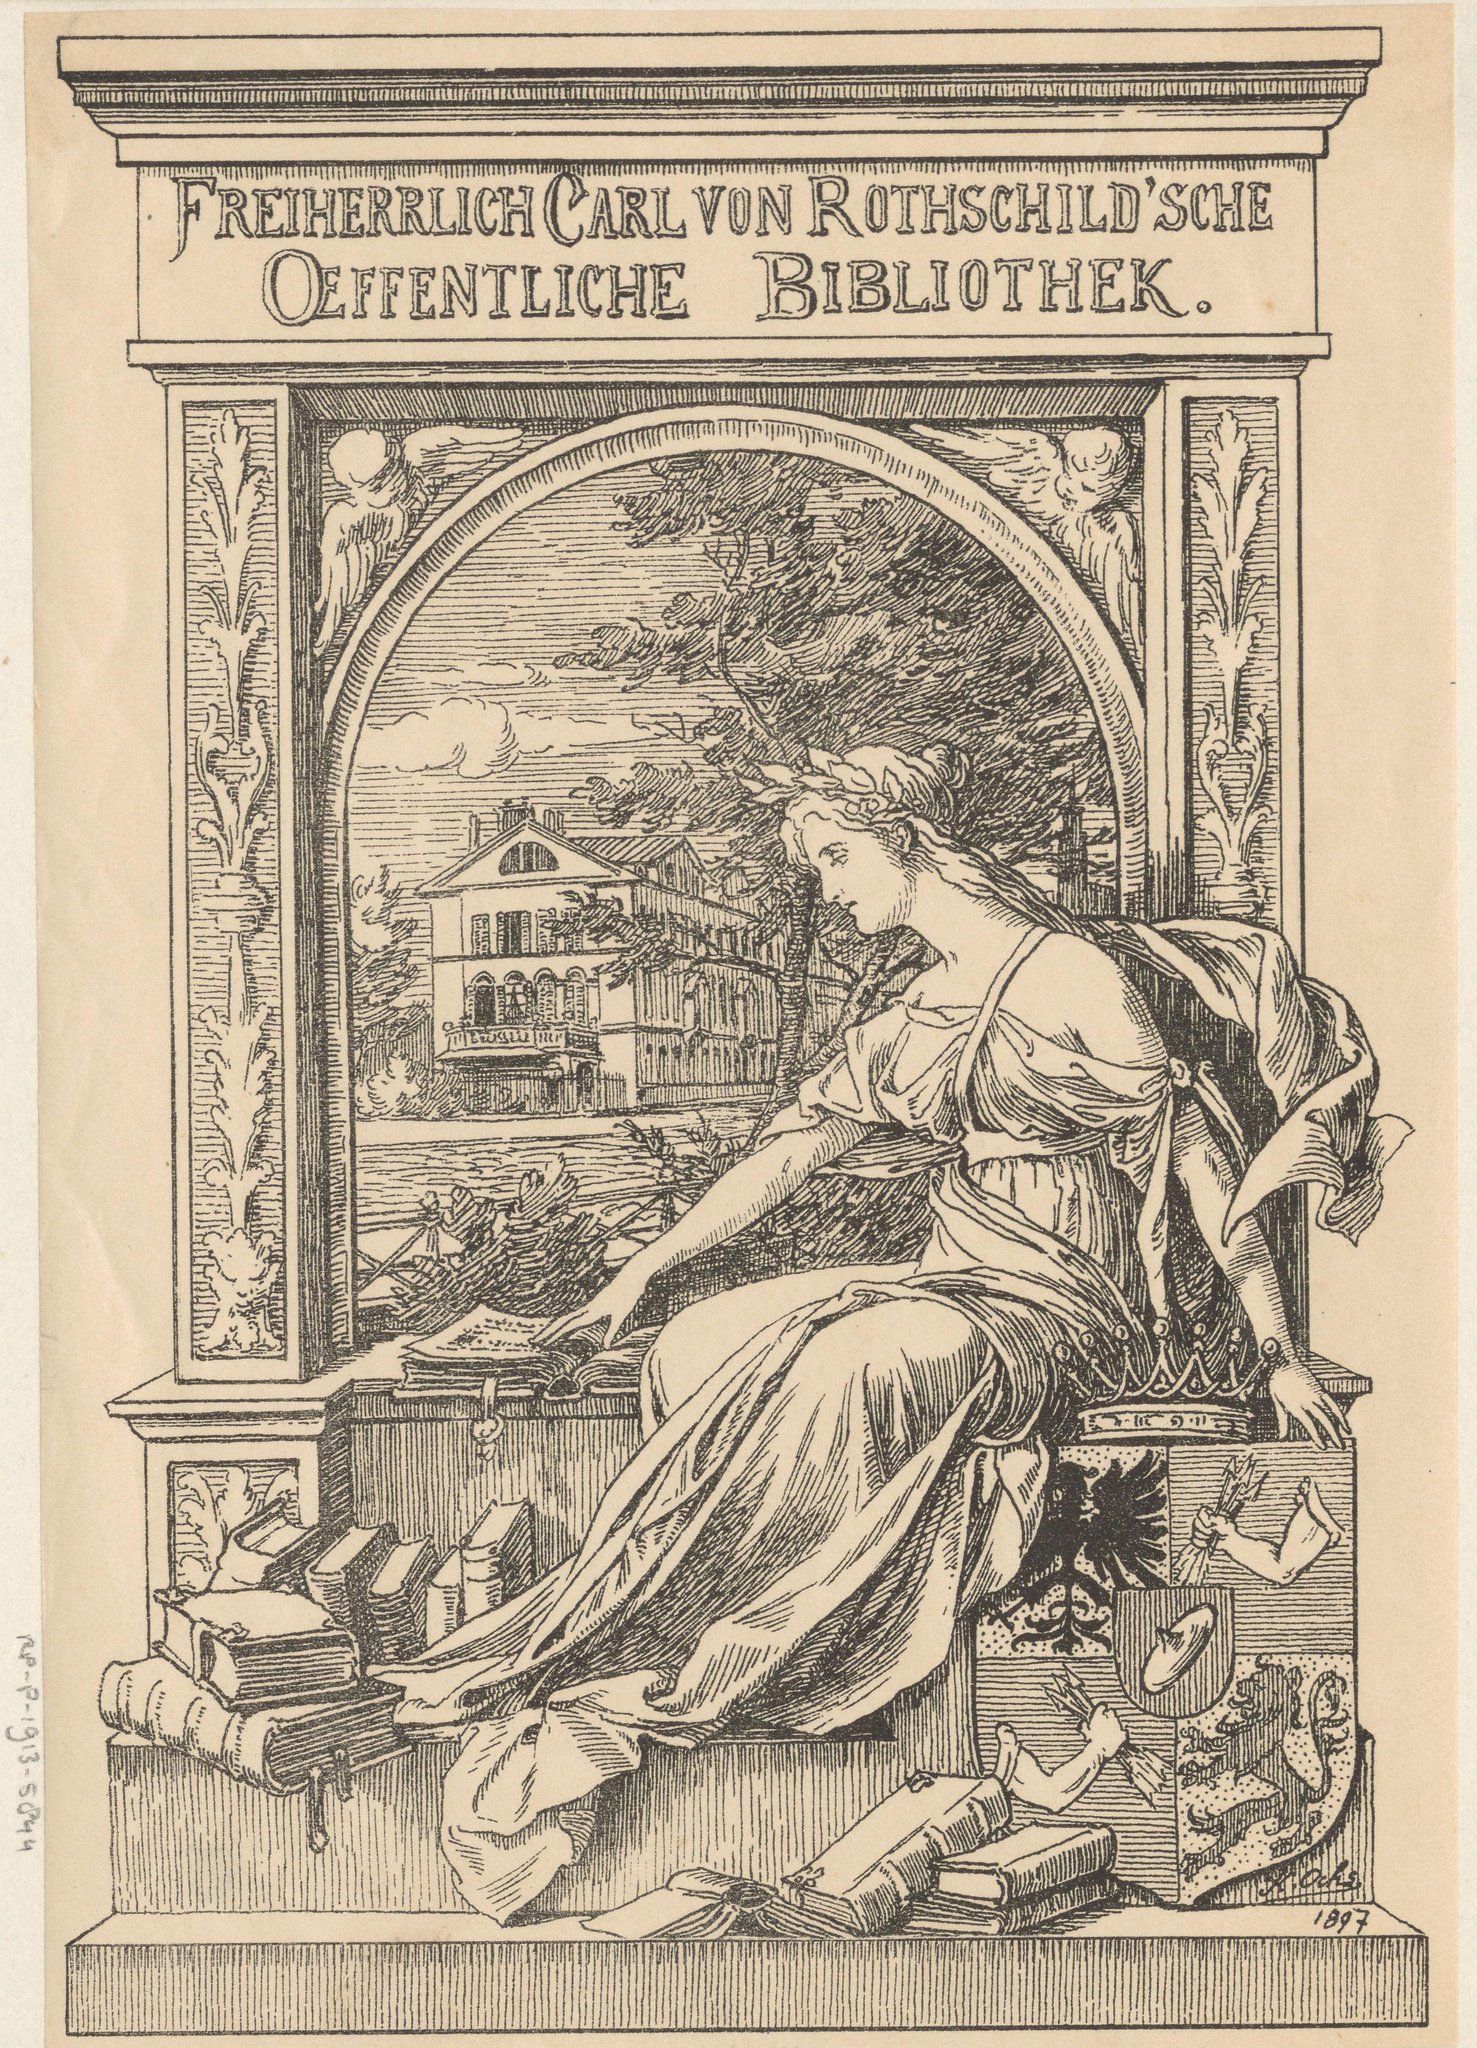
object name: bookplate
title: Freiherrlich Carl von Rothschild'sche Öffentliche Bibliothek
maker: kathinka ochs-schlenken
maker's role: print maker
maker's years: 1863-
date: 1897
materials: paper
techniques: lithograph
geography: frankfurt am main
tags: politician, sitting figure - aa - female human figure, housing, book, armorial bearing, heraldry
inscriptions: collector's mark: Lugt 2760, collector's mark: Lugt 2233